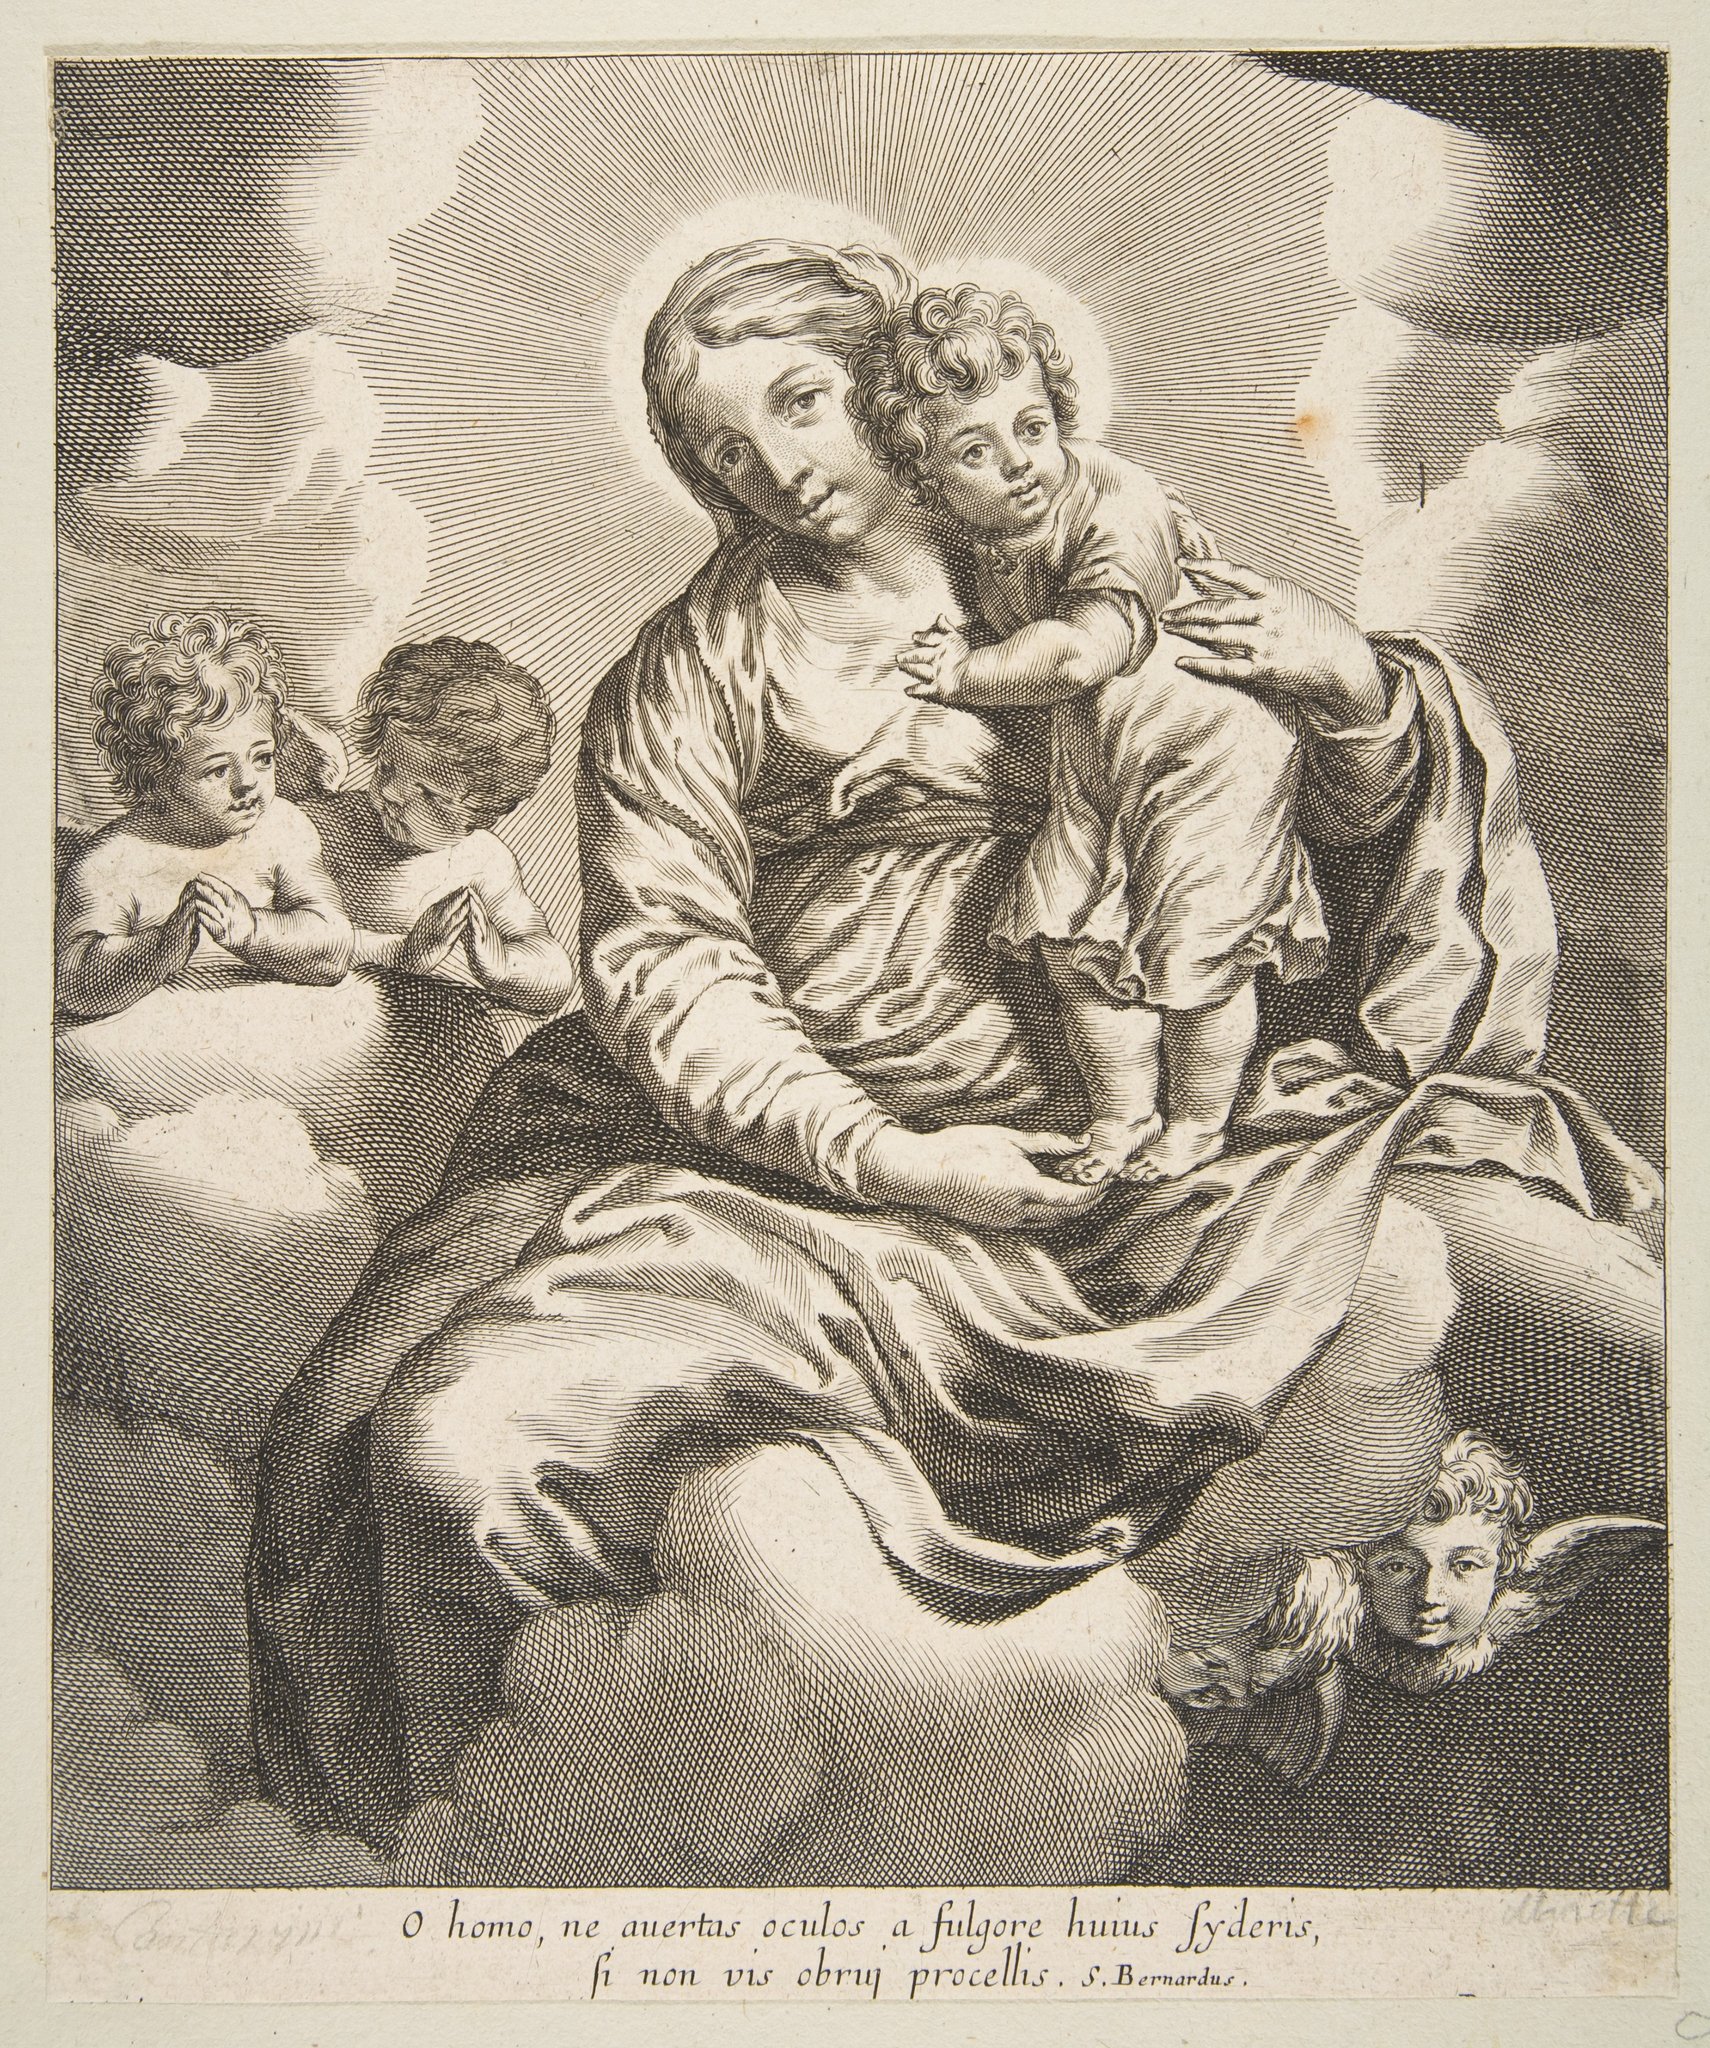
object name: print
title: Madonna and Child in Glory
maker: anonymous, 17th century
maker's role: artist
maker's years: 1600-1700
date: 1601-1700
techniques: engraving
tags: angels,madonna and child